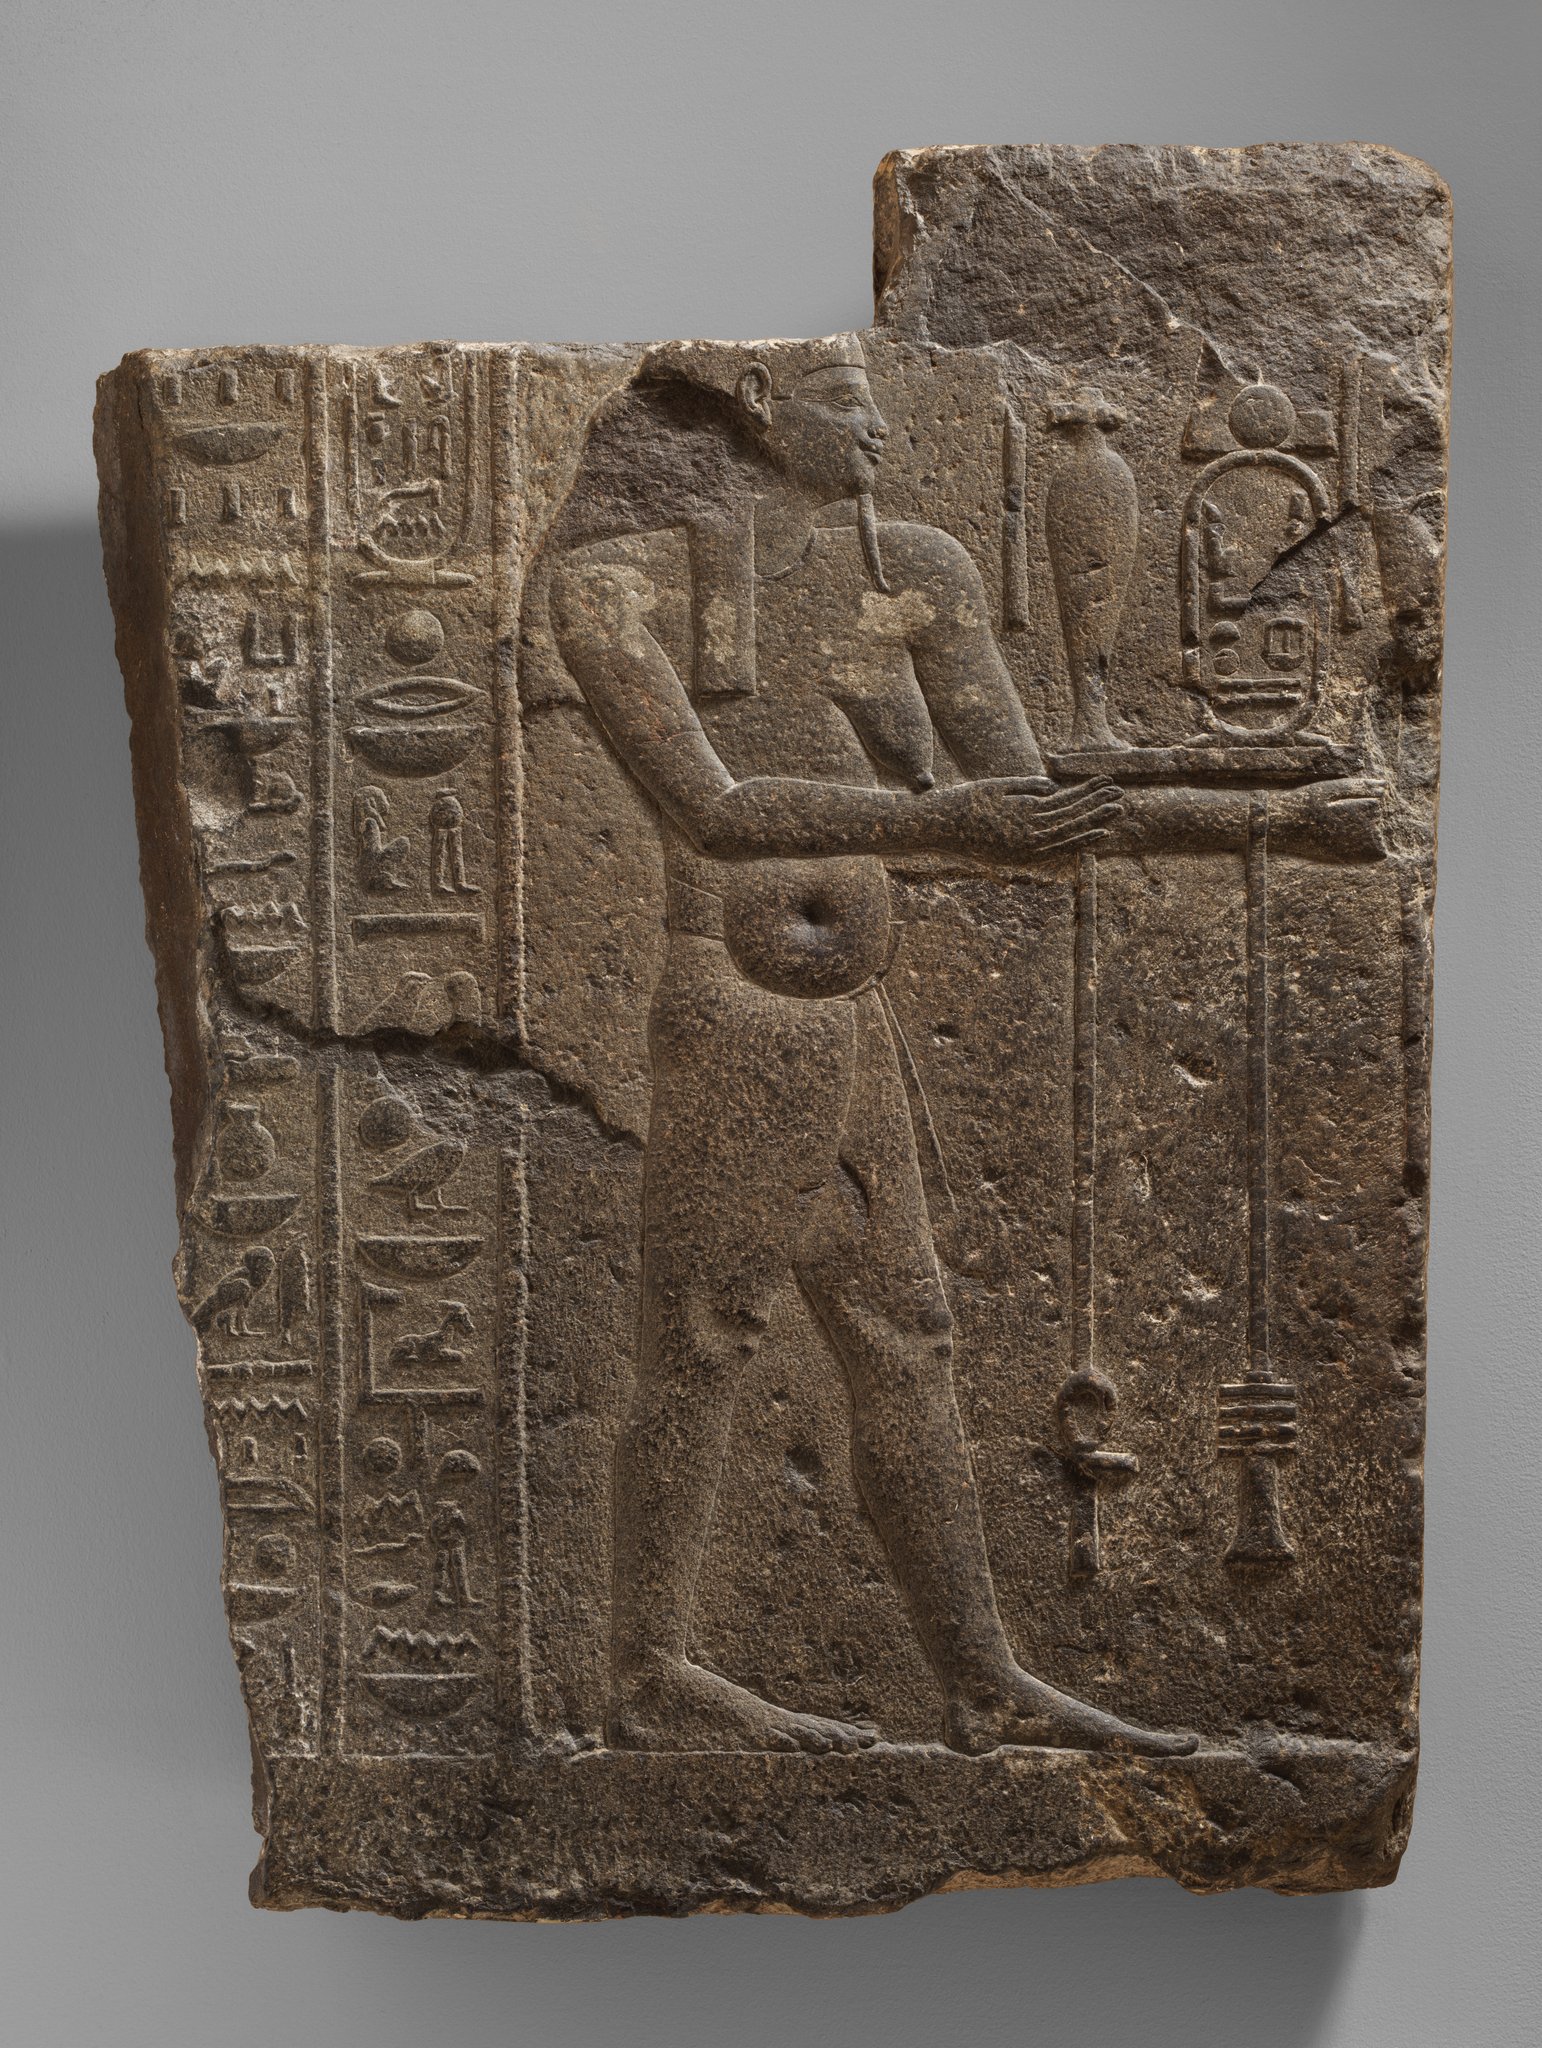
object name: relief, fecundity figure, nectanebo ii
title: Fecundity Figure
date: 360-343 BCE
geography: egypt